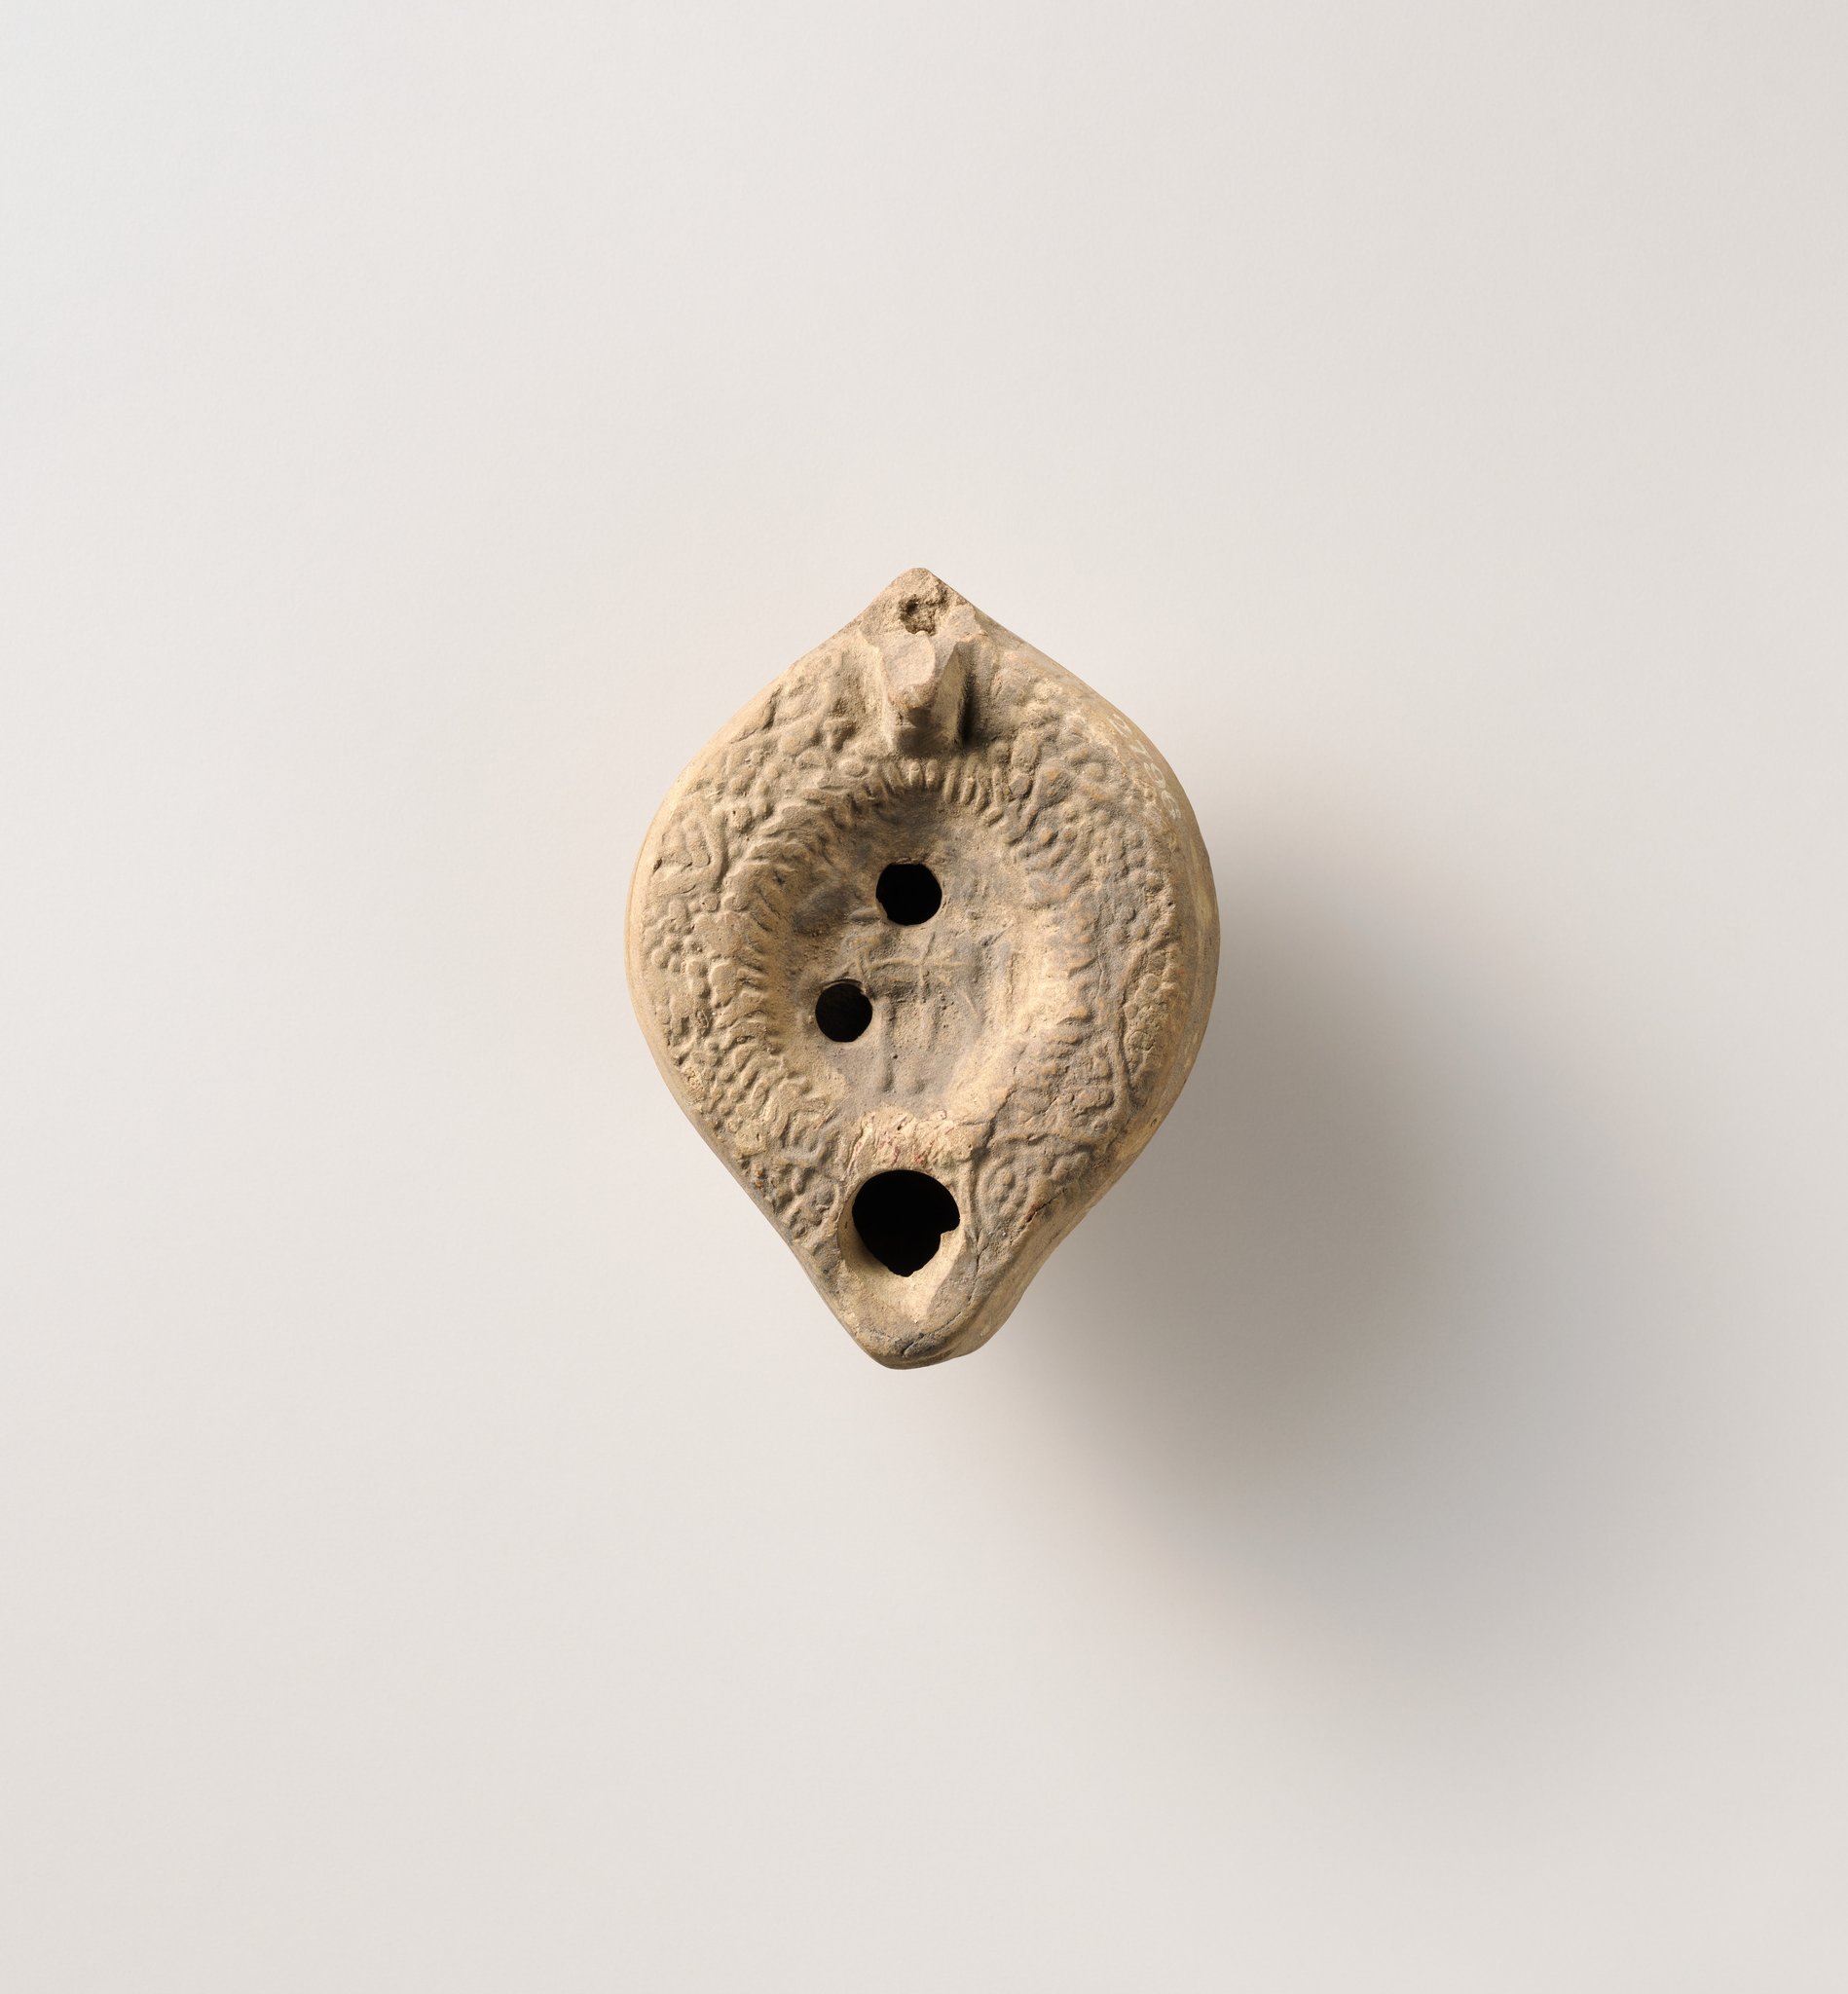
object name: lamp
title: Terracotta oil lamp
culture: roman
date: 201-300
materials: terracotta